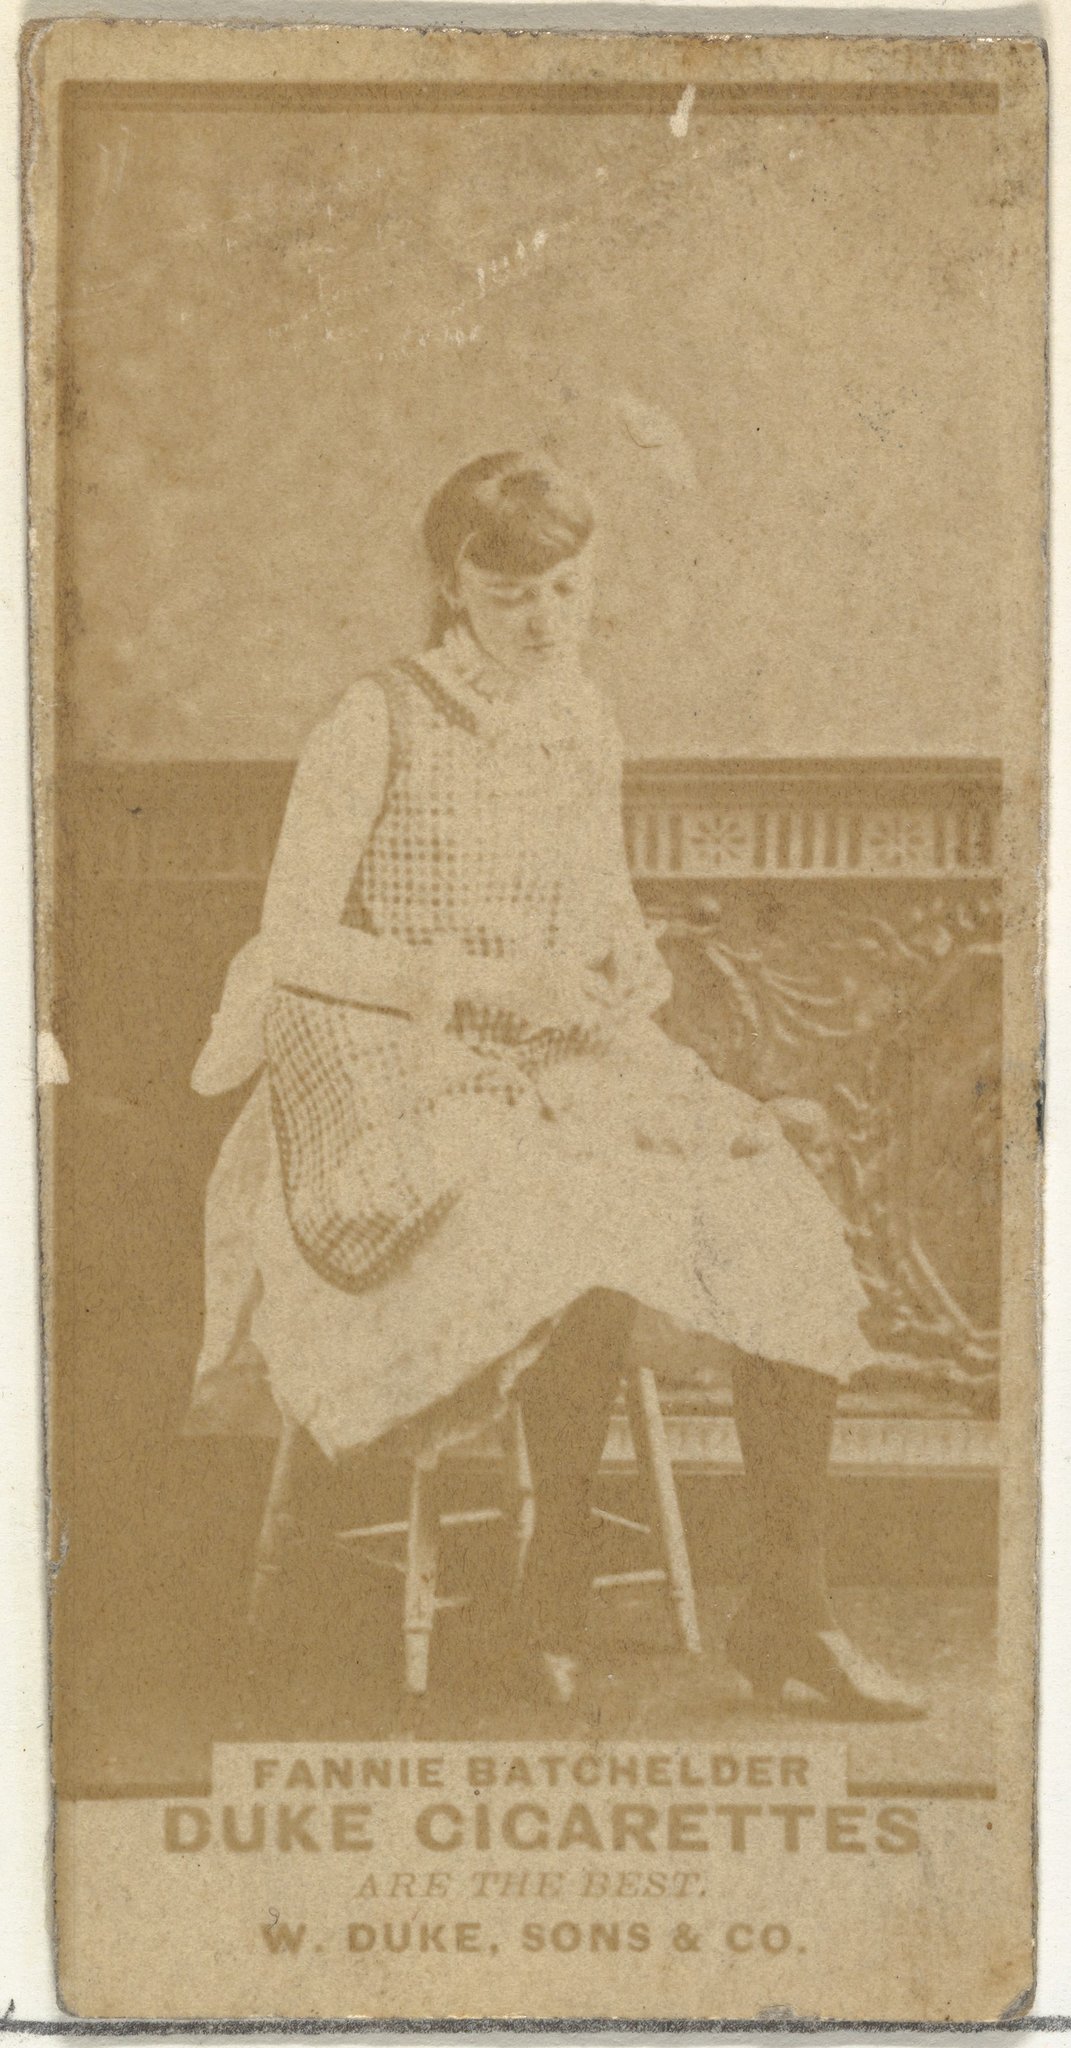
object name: photograph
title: Fannie Batchelder, from the Actors and Actresses series (N145-7) issued by Duke Sons & Co. to promote Duke Cigarettes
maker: w. duke, sons & co.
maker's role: publisher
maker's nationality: american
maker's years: 1870-1920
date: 1880-1889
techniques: albumen silver print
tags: portraits,women,actresses